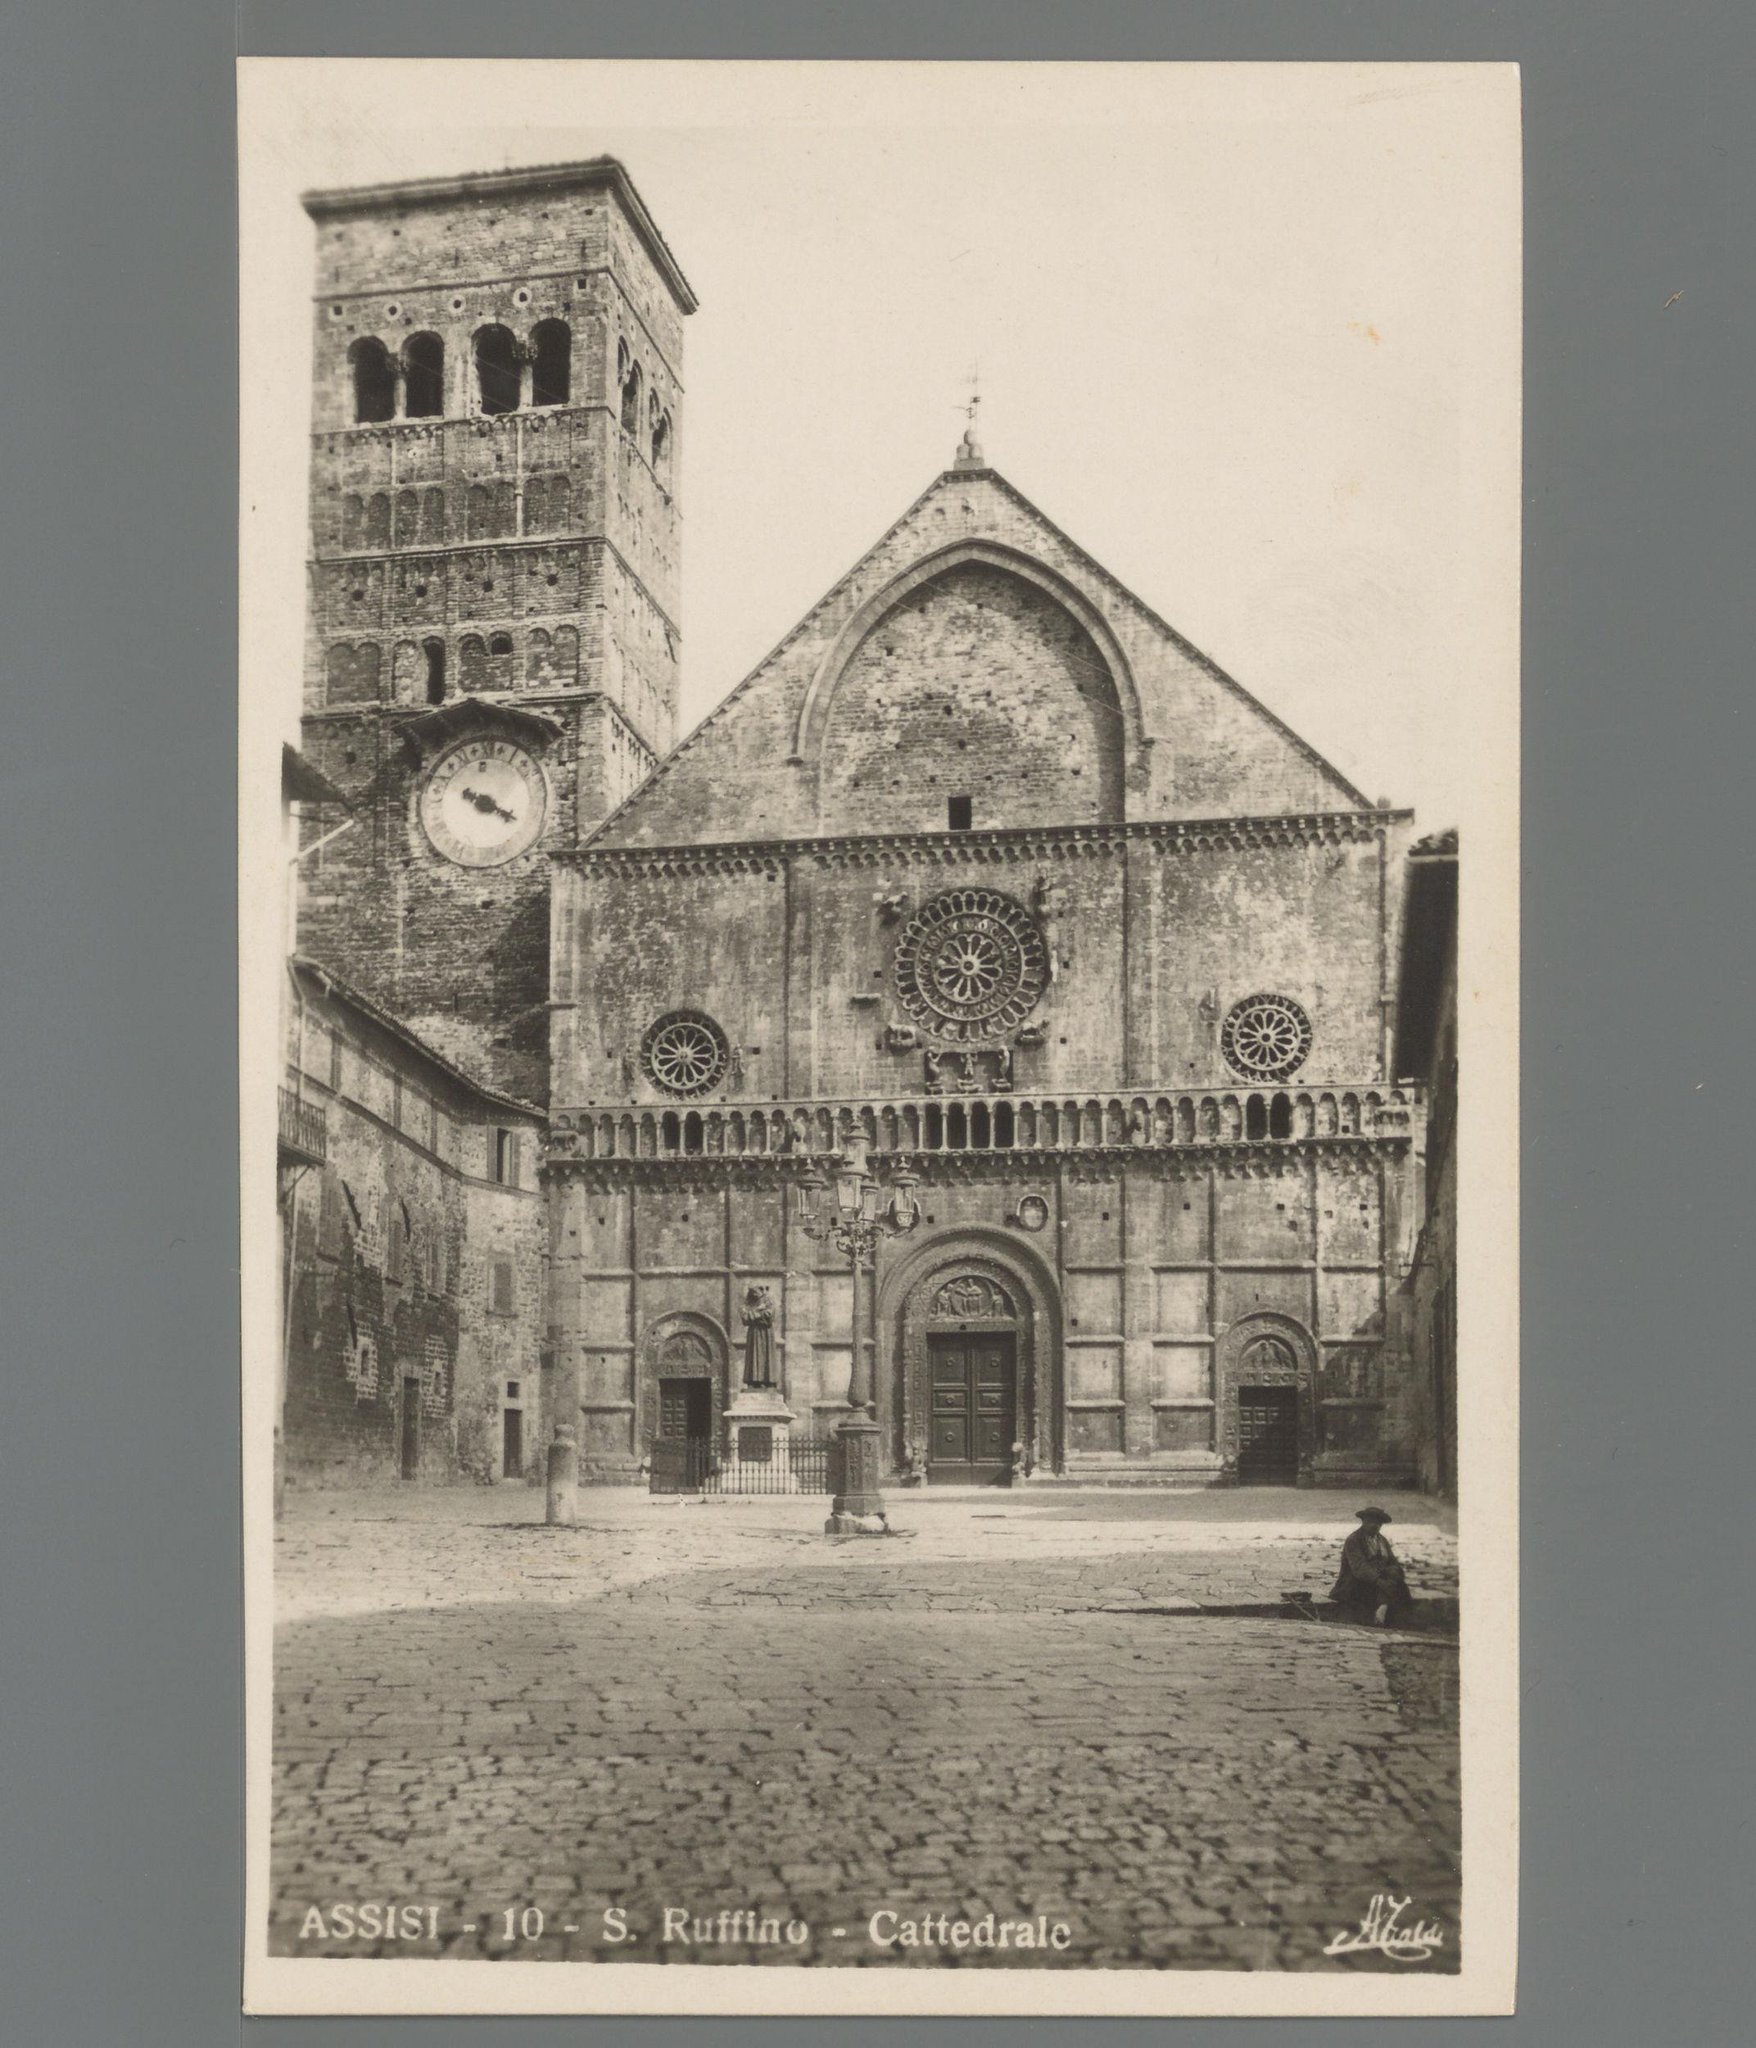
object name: photograph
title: Assisi. S. Ruffino. Cattedrale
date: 1906-1930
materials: photographic support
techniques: photography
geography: assisi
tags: church (exterior), square, place, circus, etc. (+ city(-scape) with figures, staffage)